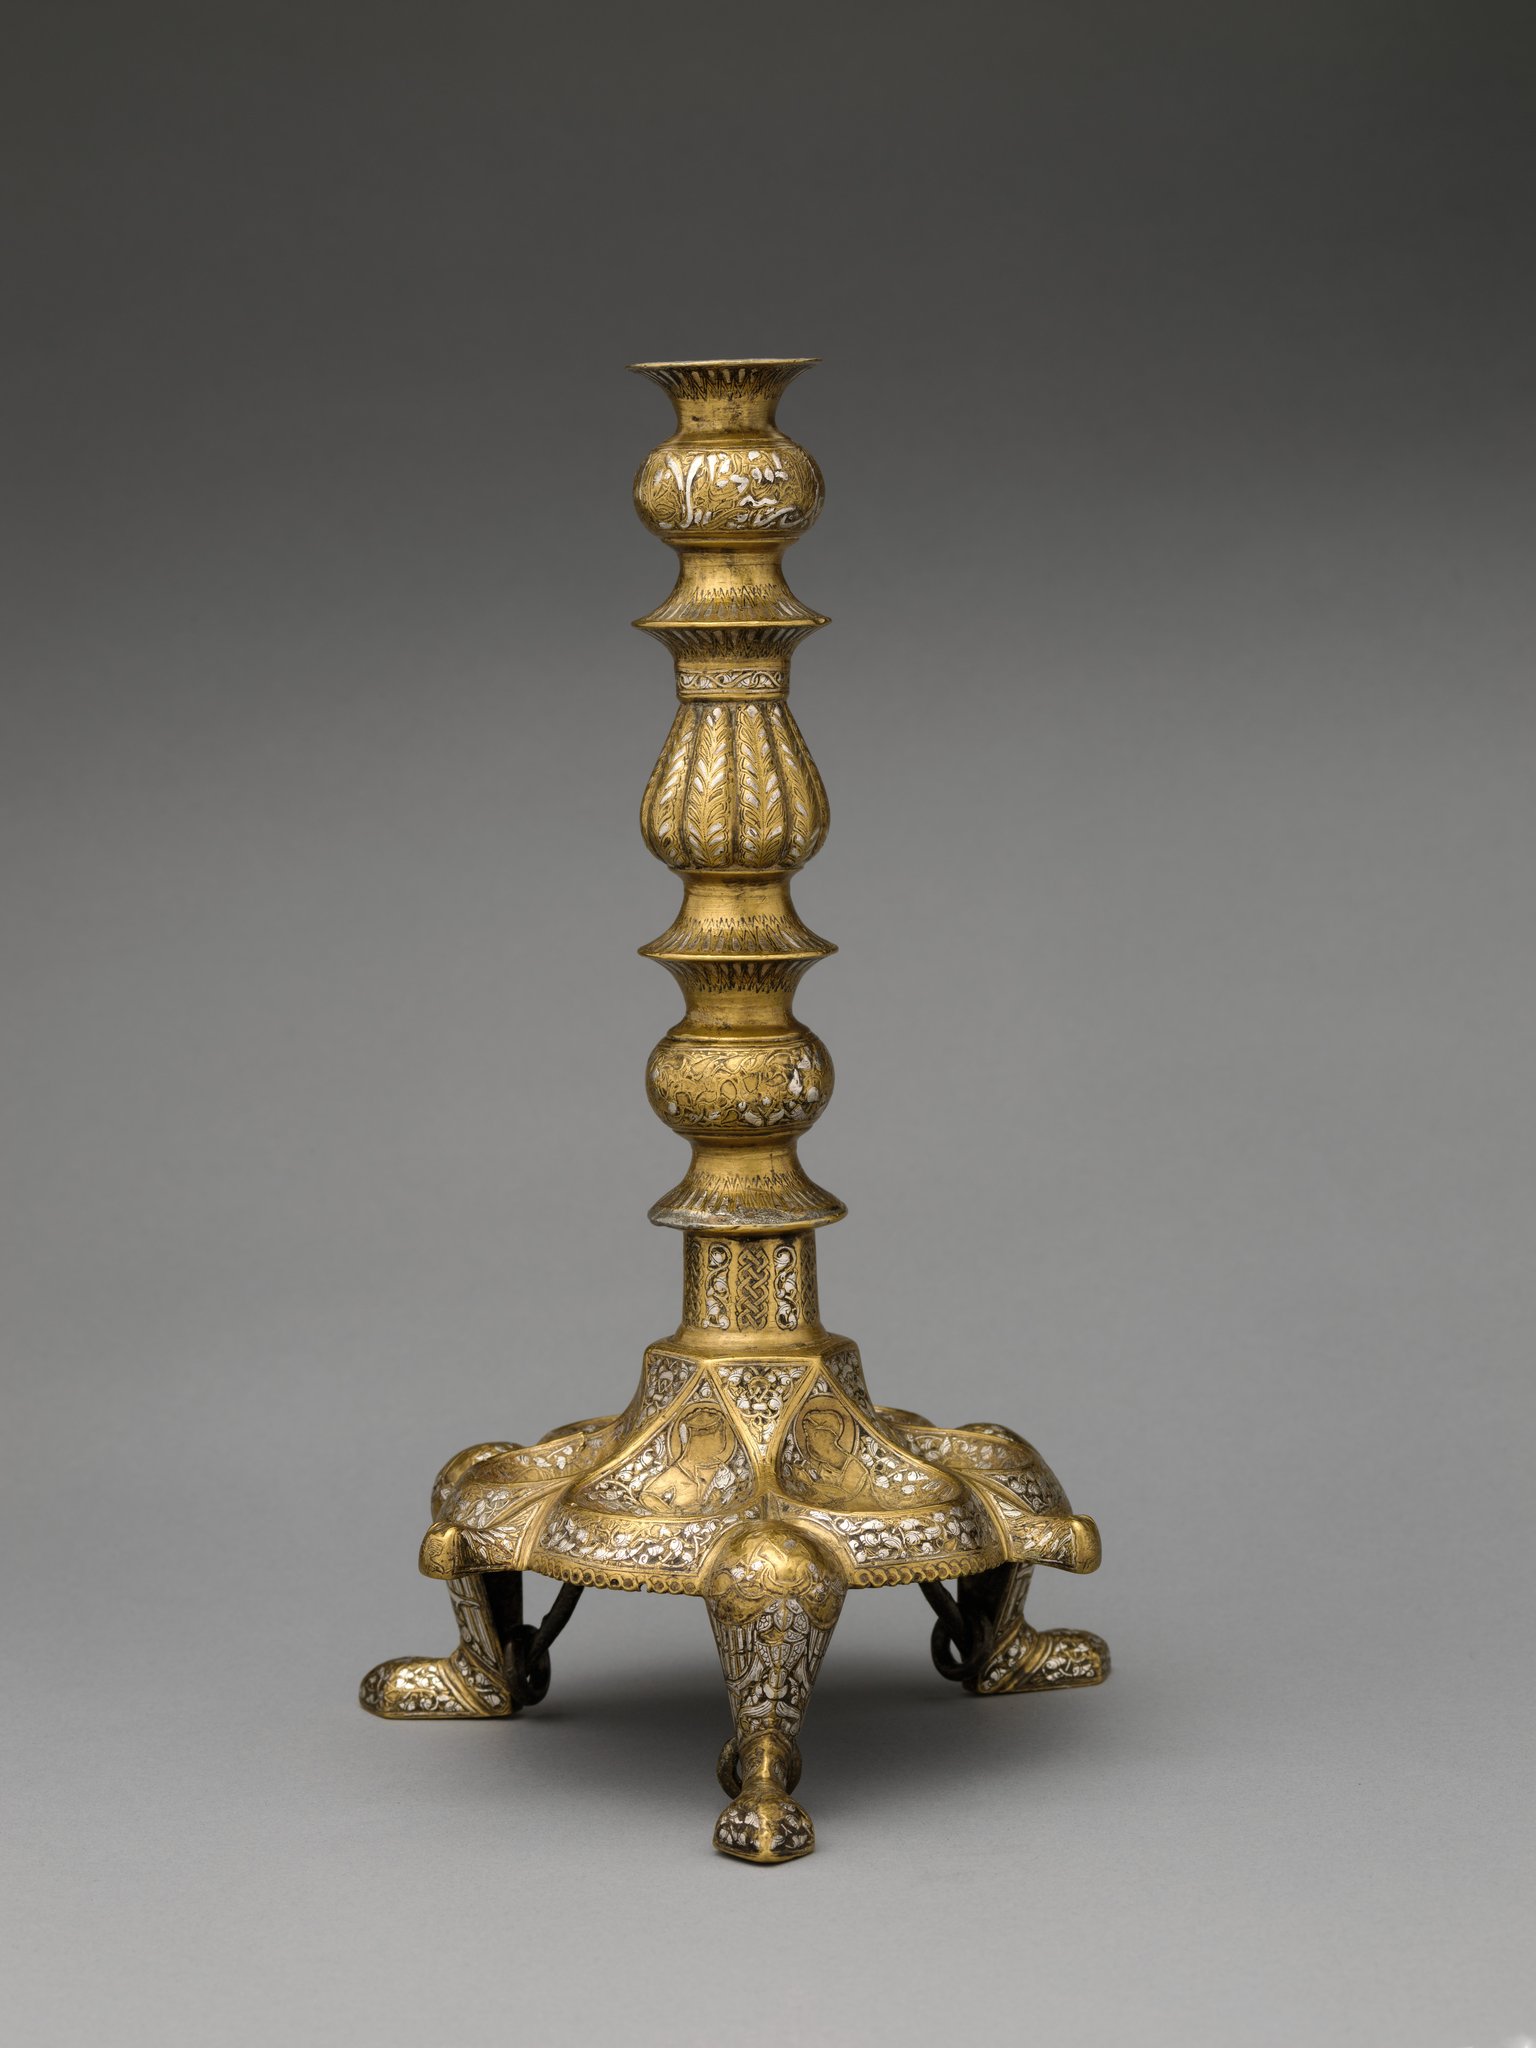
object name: candlestick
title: Tripod Candlestick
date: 1250-1300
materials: brass, gold, silver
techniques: inlay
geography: syria